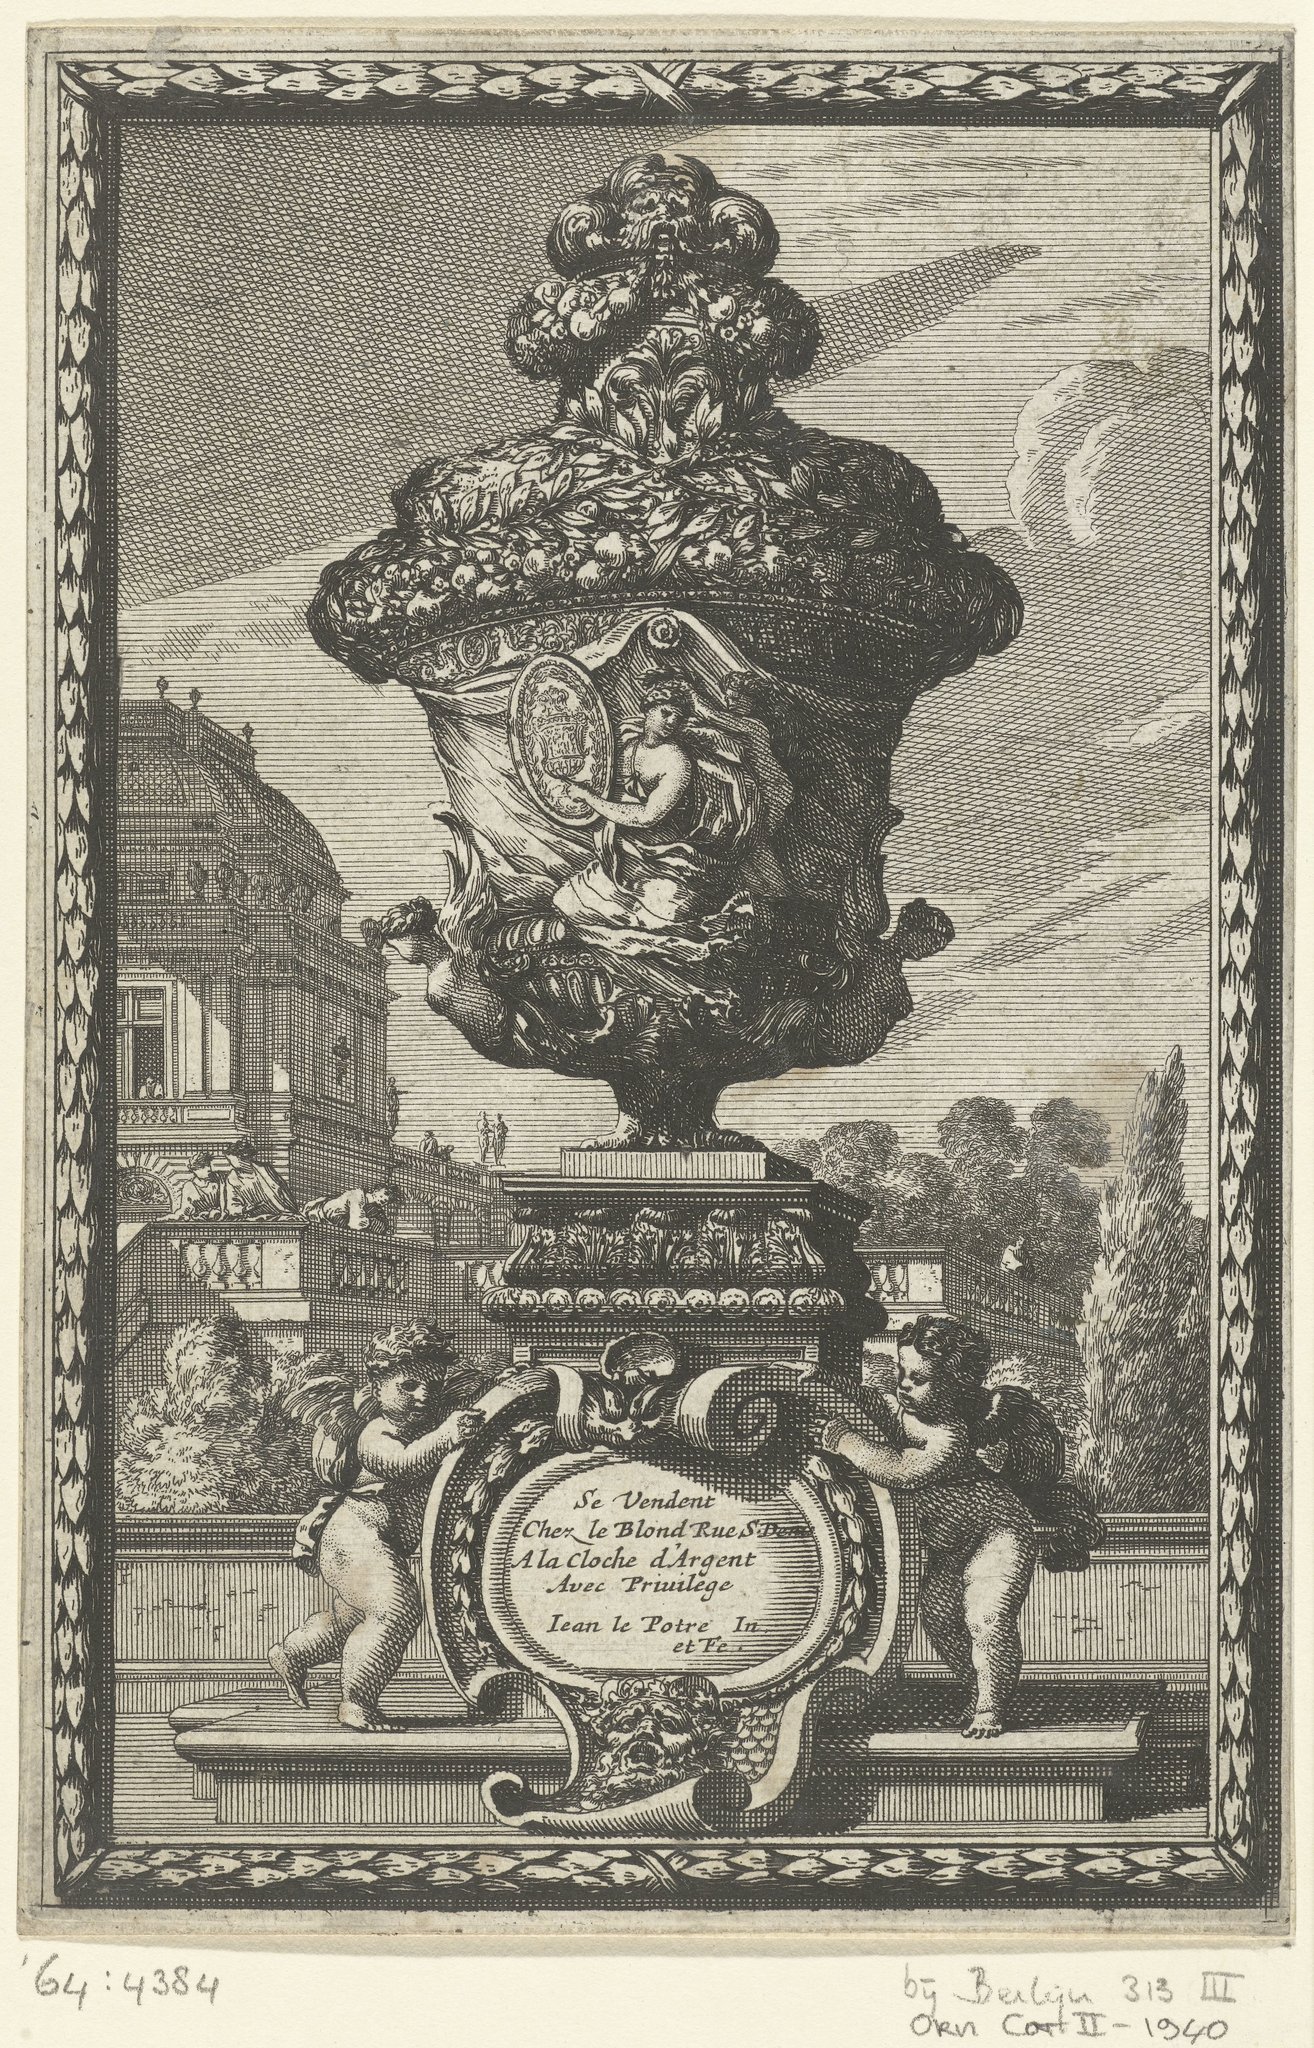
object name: print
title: Titelblad: vazen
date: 1648-1655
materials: paper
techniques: etching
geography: france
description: Vaas gedecoreerd met een knielende vrouw die een ovaal medaillon met een vaas vasthoudt. Uit serie van 6 bladen.